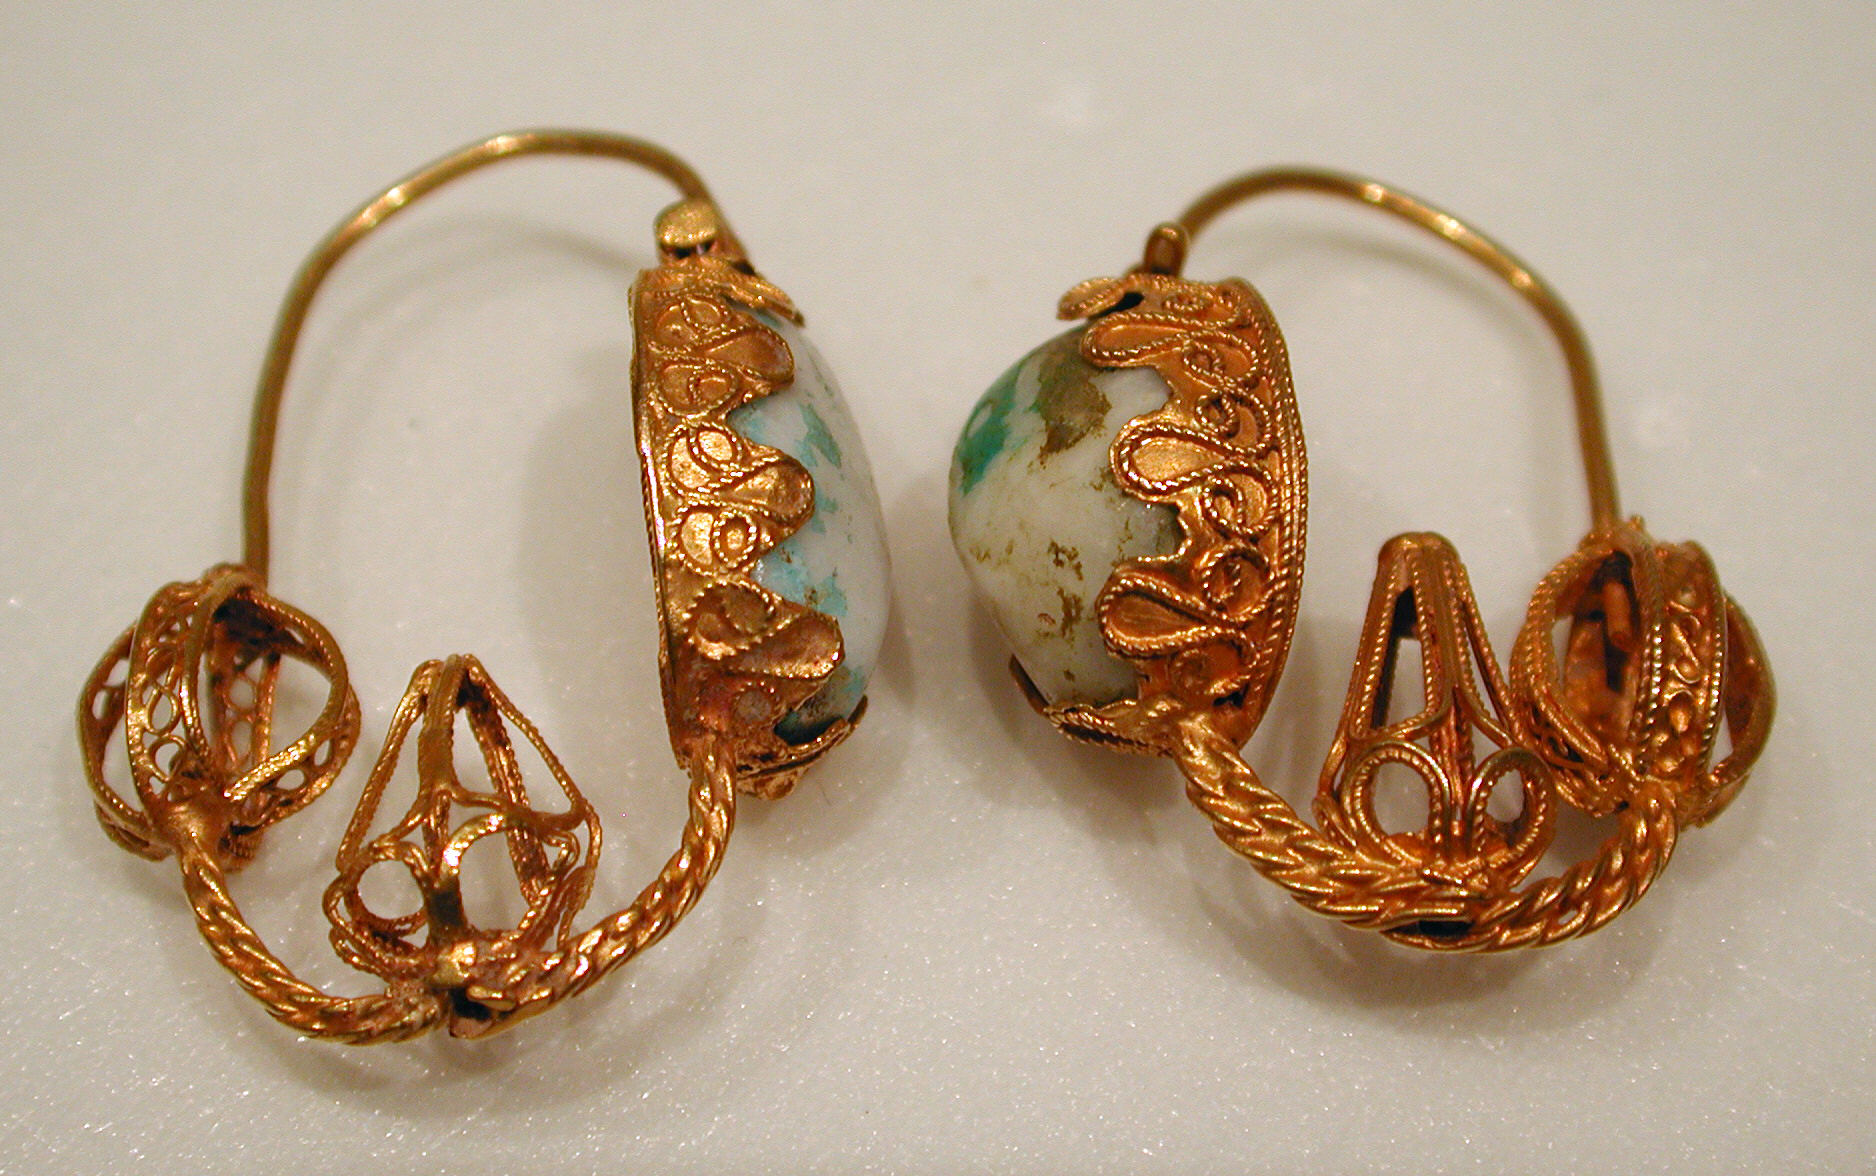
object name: earring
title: Earring, One of a Pair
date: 1101-1200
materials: gold, stone, metal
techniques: filigree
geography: iran